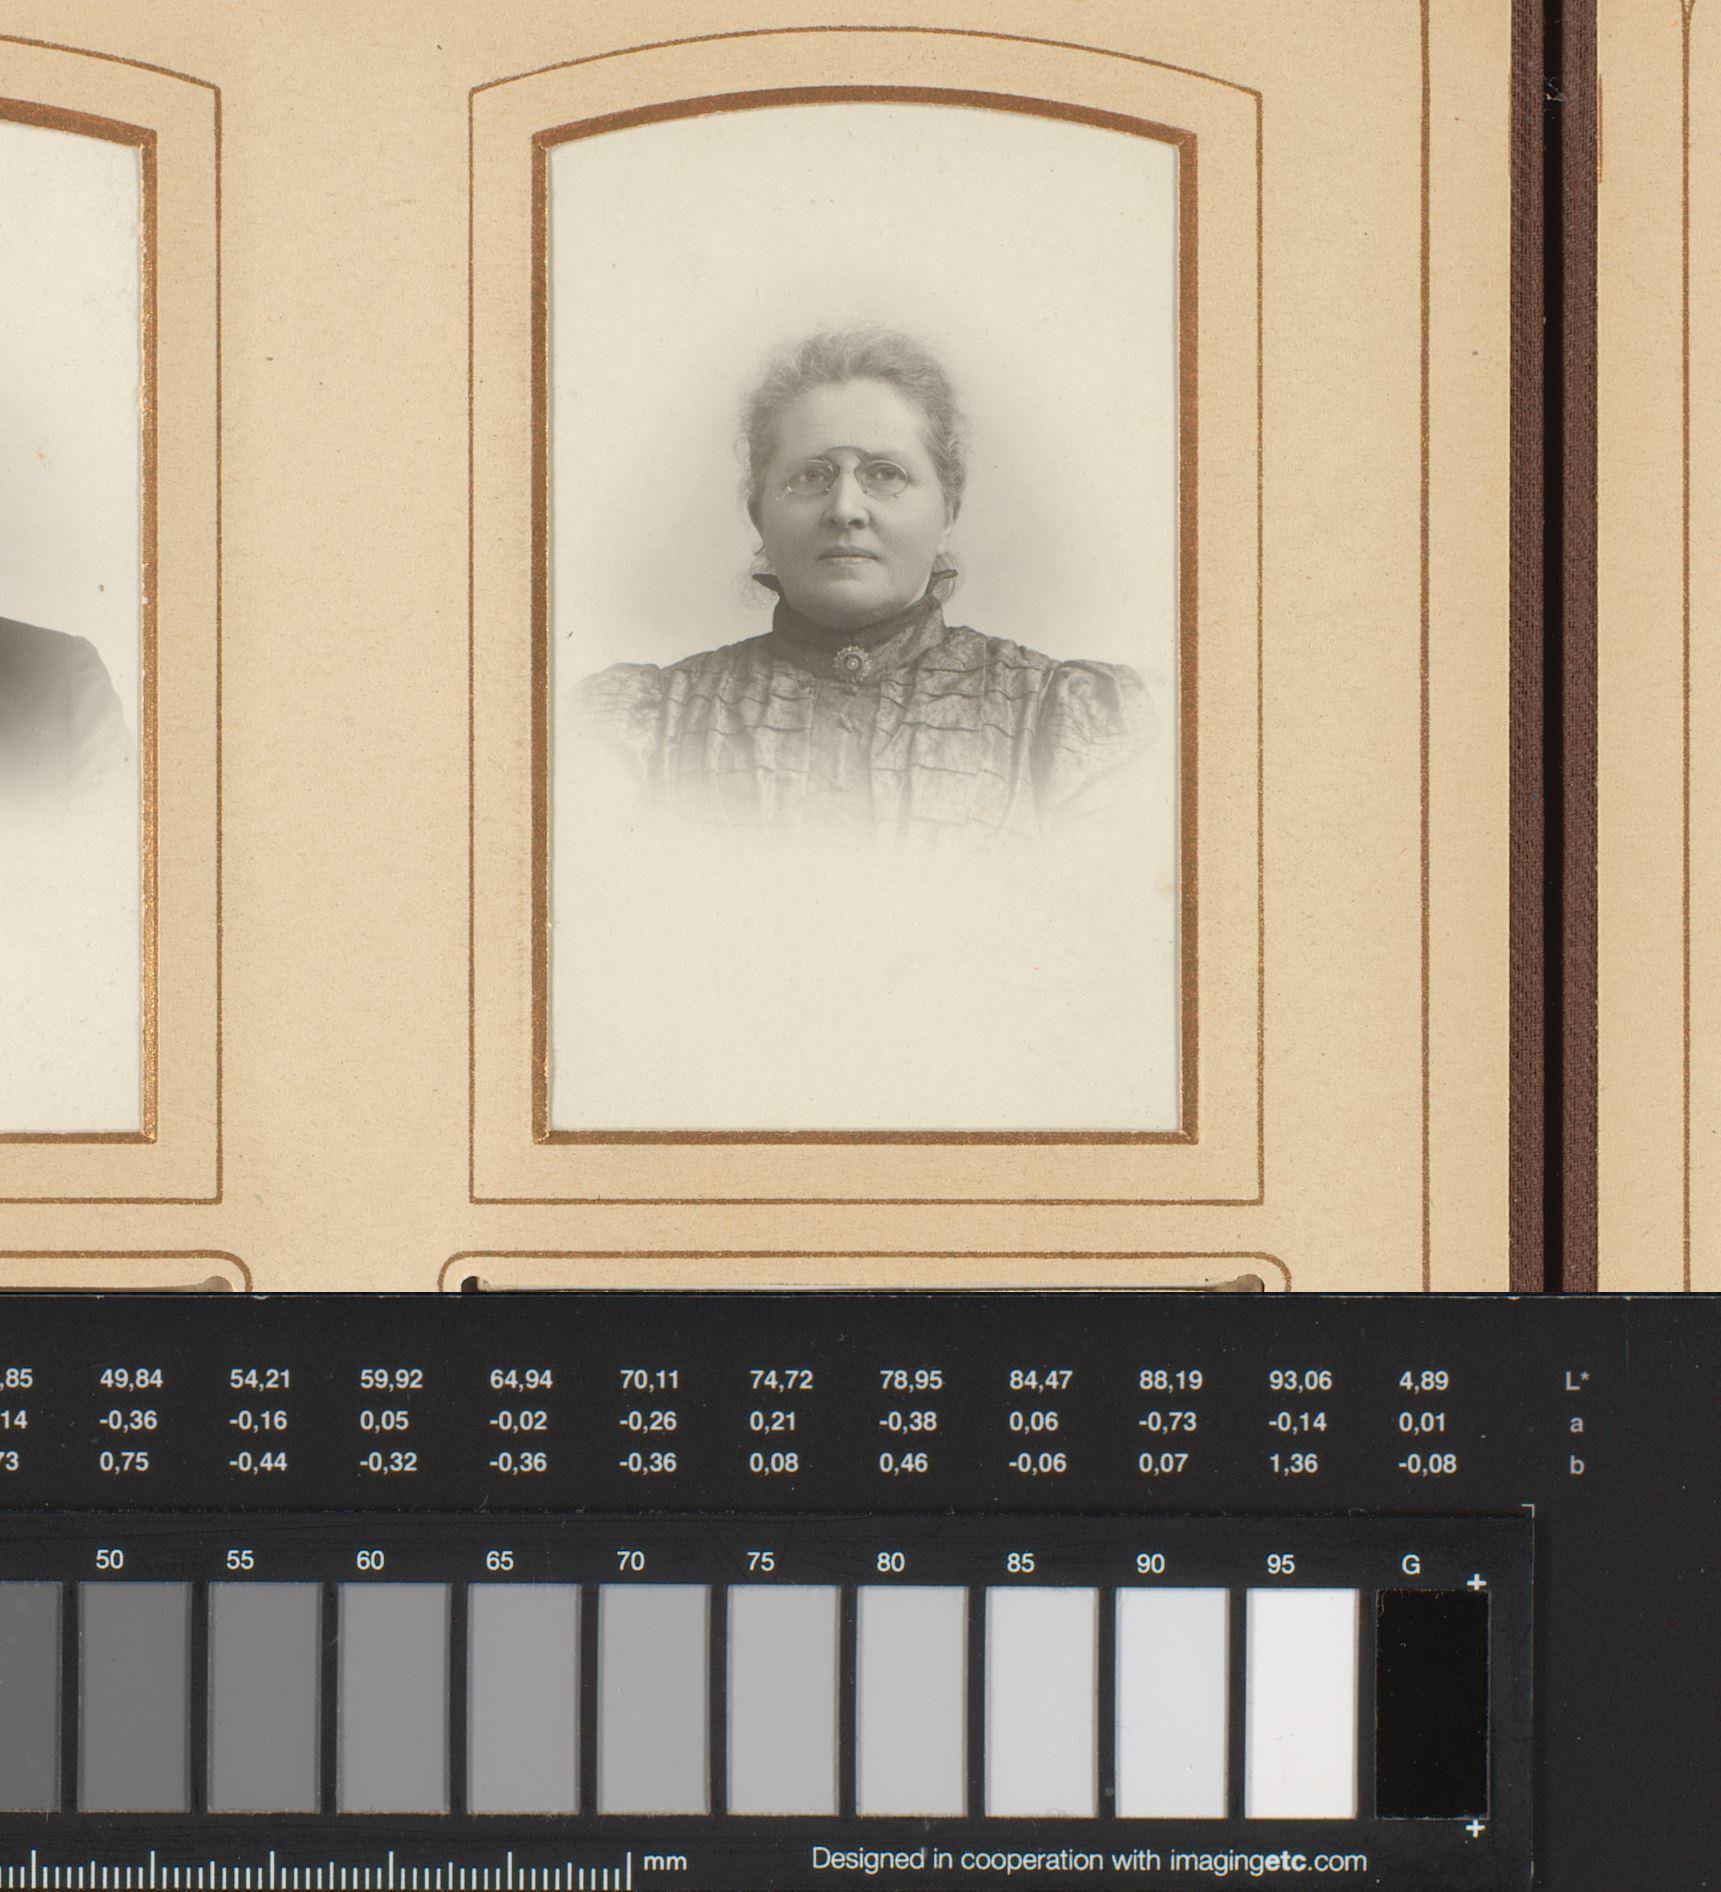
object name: album leaf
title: Portret van een vrouw met bril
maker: Anonymous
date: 1890-1920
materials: cardboard, photographic support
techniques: collodion silver print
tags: eyeglasses, spectacles, historical persons - bb - woman